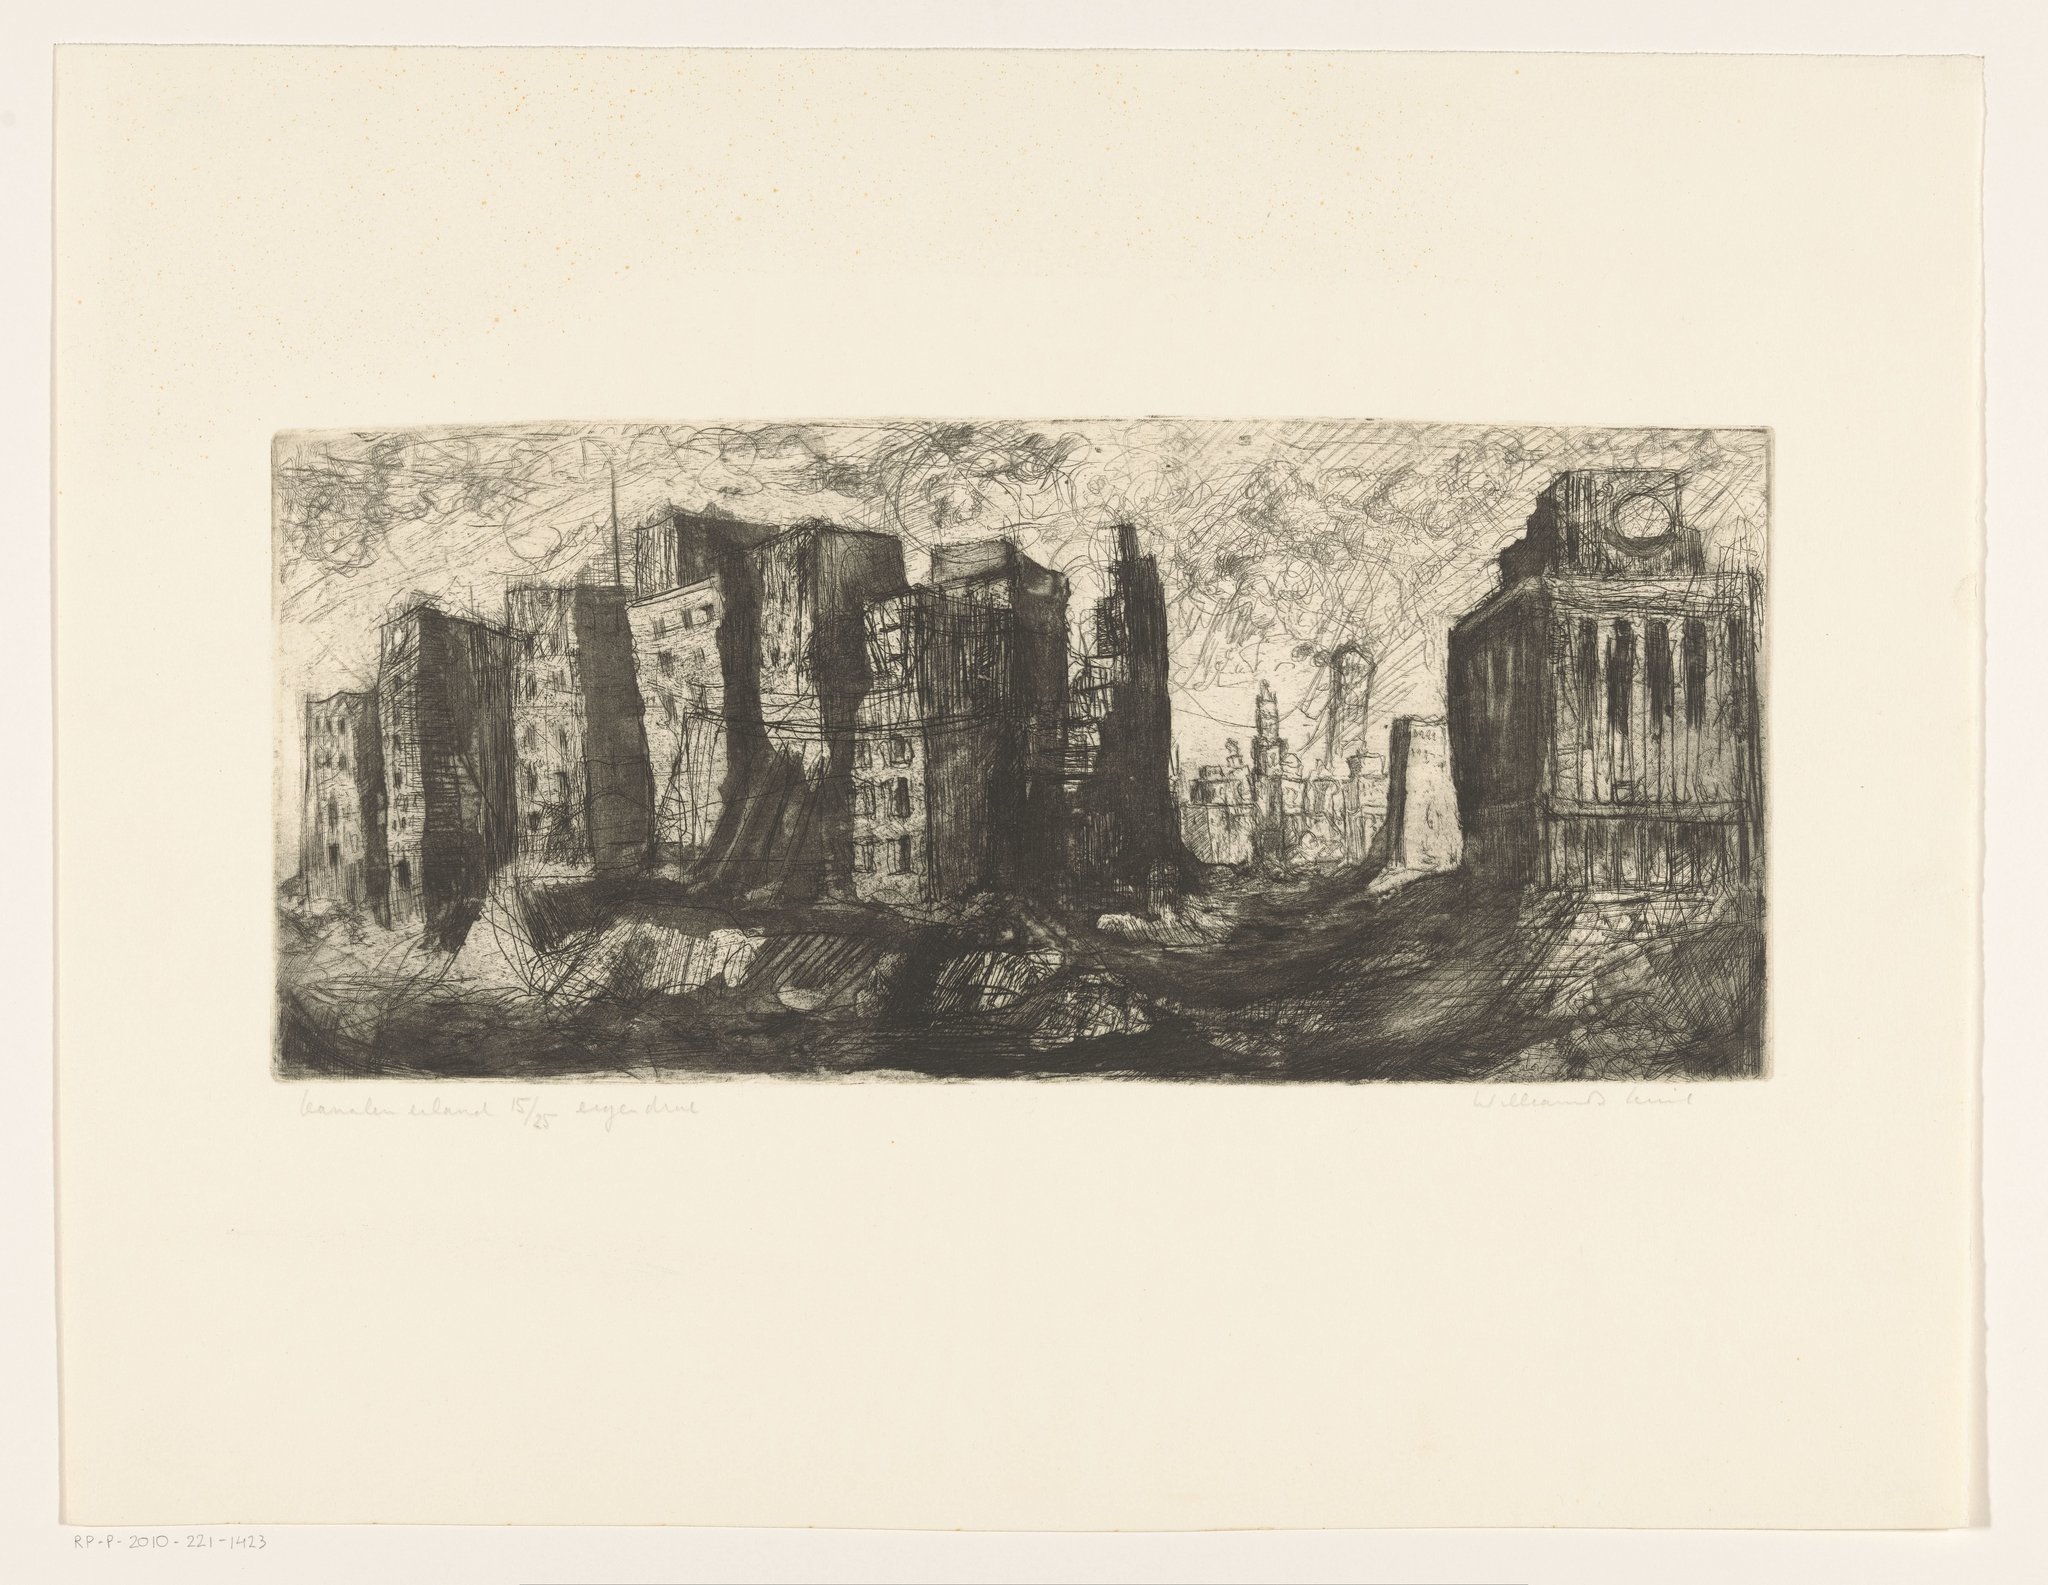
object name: print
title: Kanaleneiland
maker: dirkje kuik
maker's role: print maker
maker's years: 1929-2008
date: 1950-1964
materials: ink, paper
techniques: aquatint, drypoint, etching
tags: utrecht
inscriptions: edition: ‘15/25 eigen druk.’, signature: ‘WillemD. Kuik’, title: ‘kanalen eiland’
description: Stadsgezicht, schetsmatig weergegeven, met rechts van het midden een doorkijk naar enkele torens.